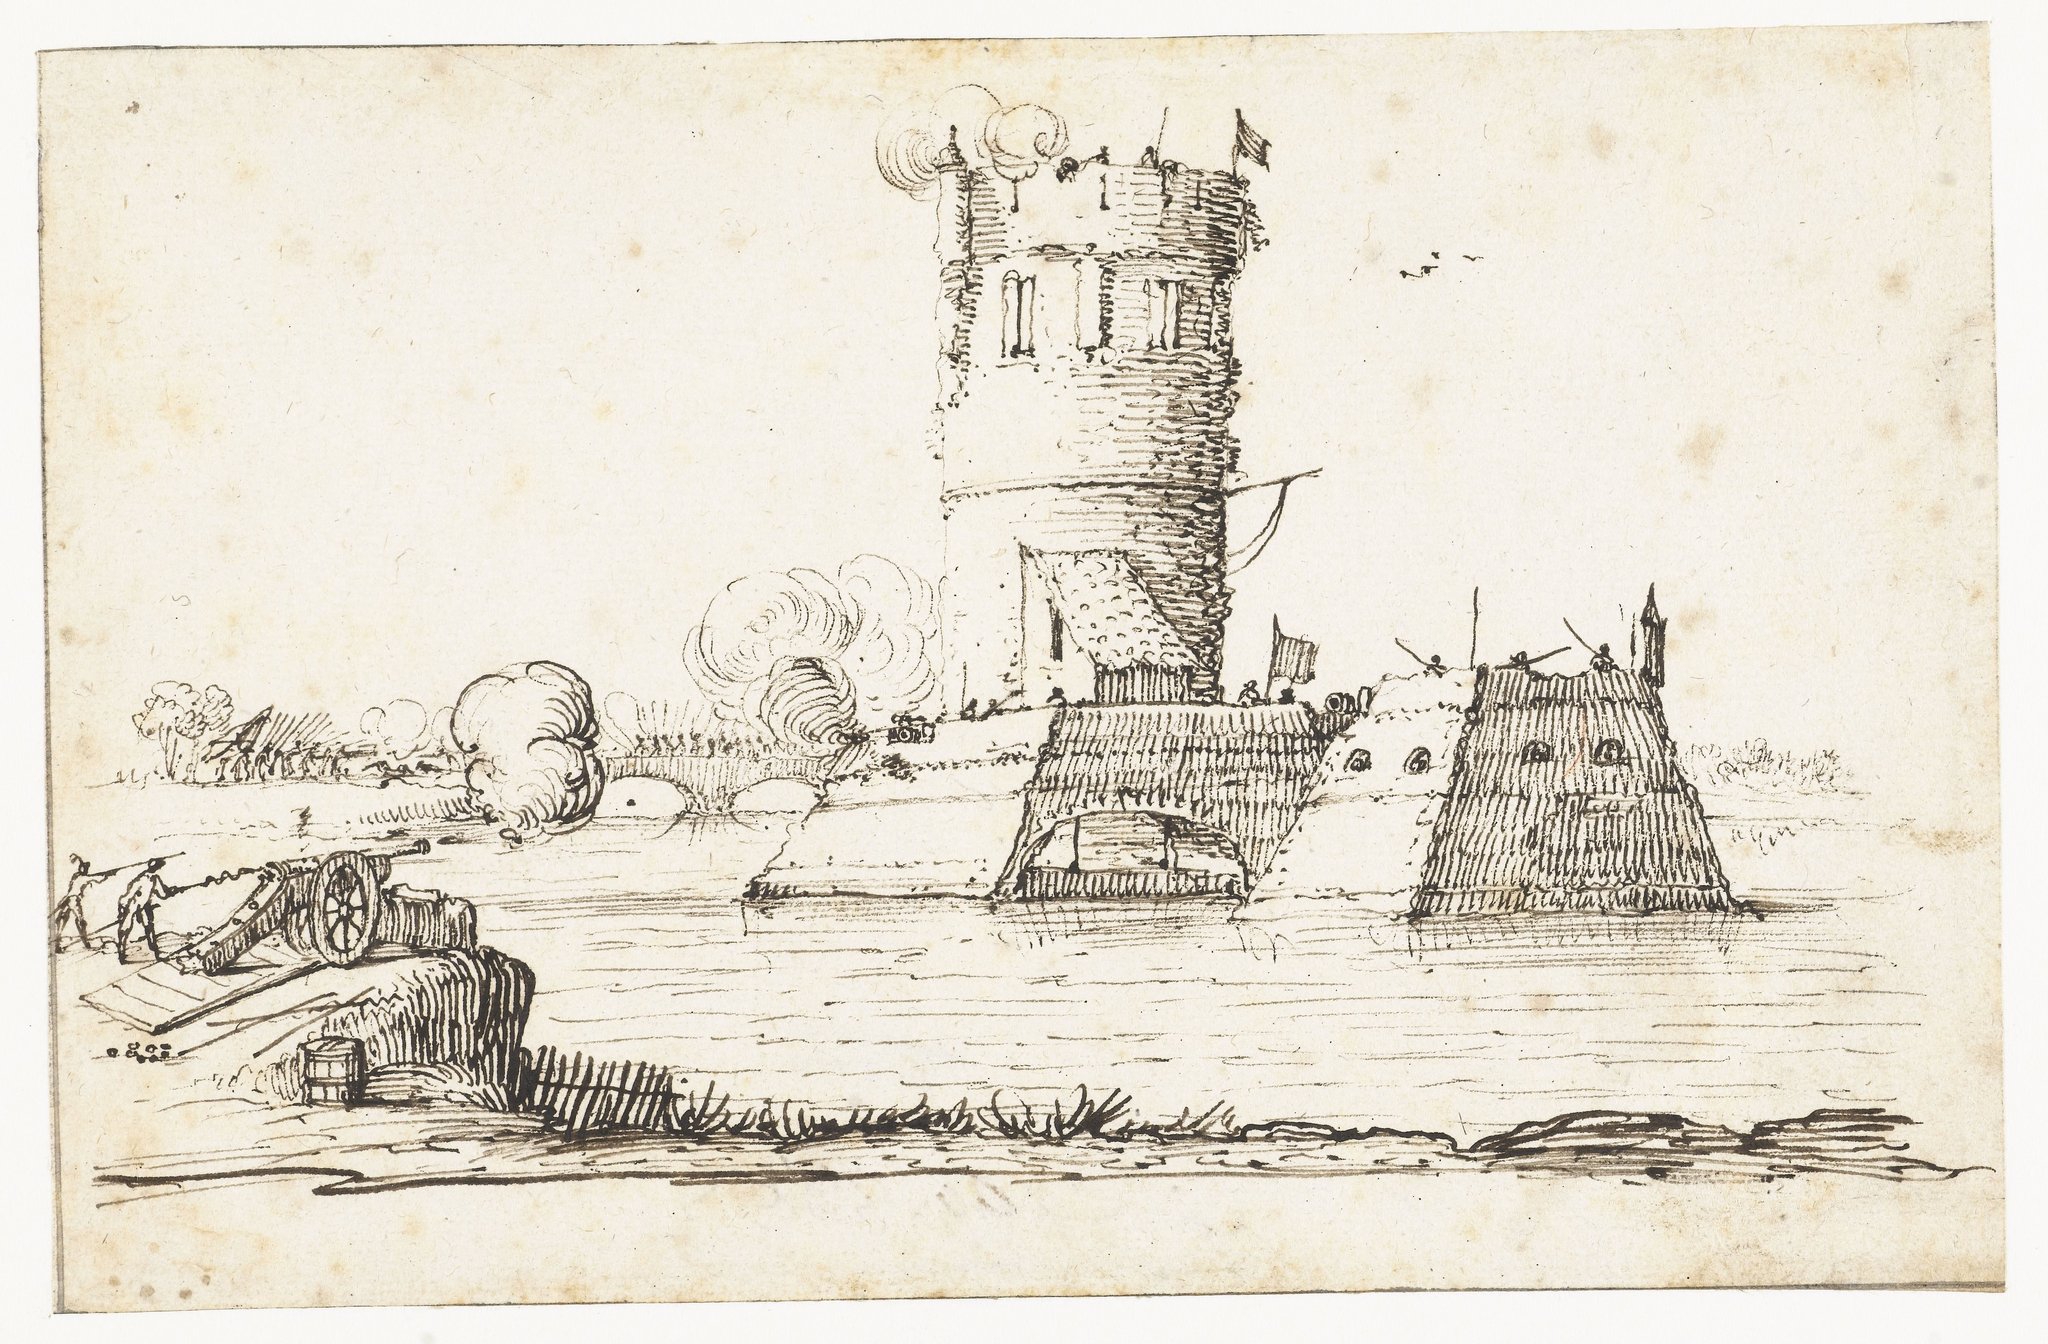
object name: drawing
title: Aanval van artillerie op een verdedigingstoren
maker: albert flamen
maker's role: draughtsman, print maker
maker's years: 1620-1691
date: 1648-1669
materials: ink, paper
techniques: pen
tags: attack ~ siege, defence ~ siege, battle (+ land forces)